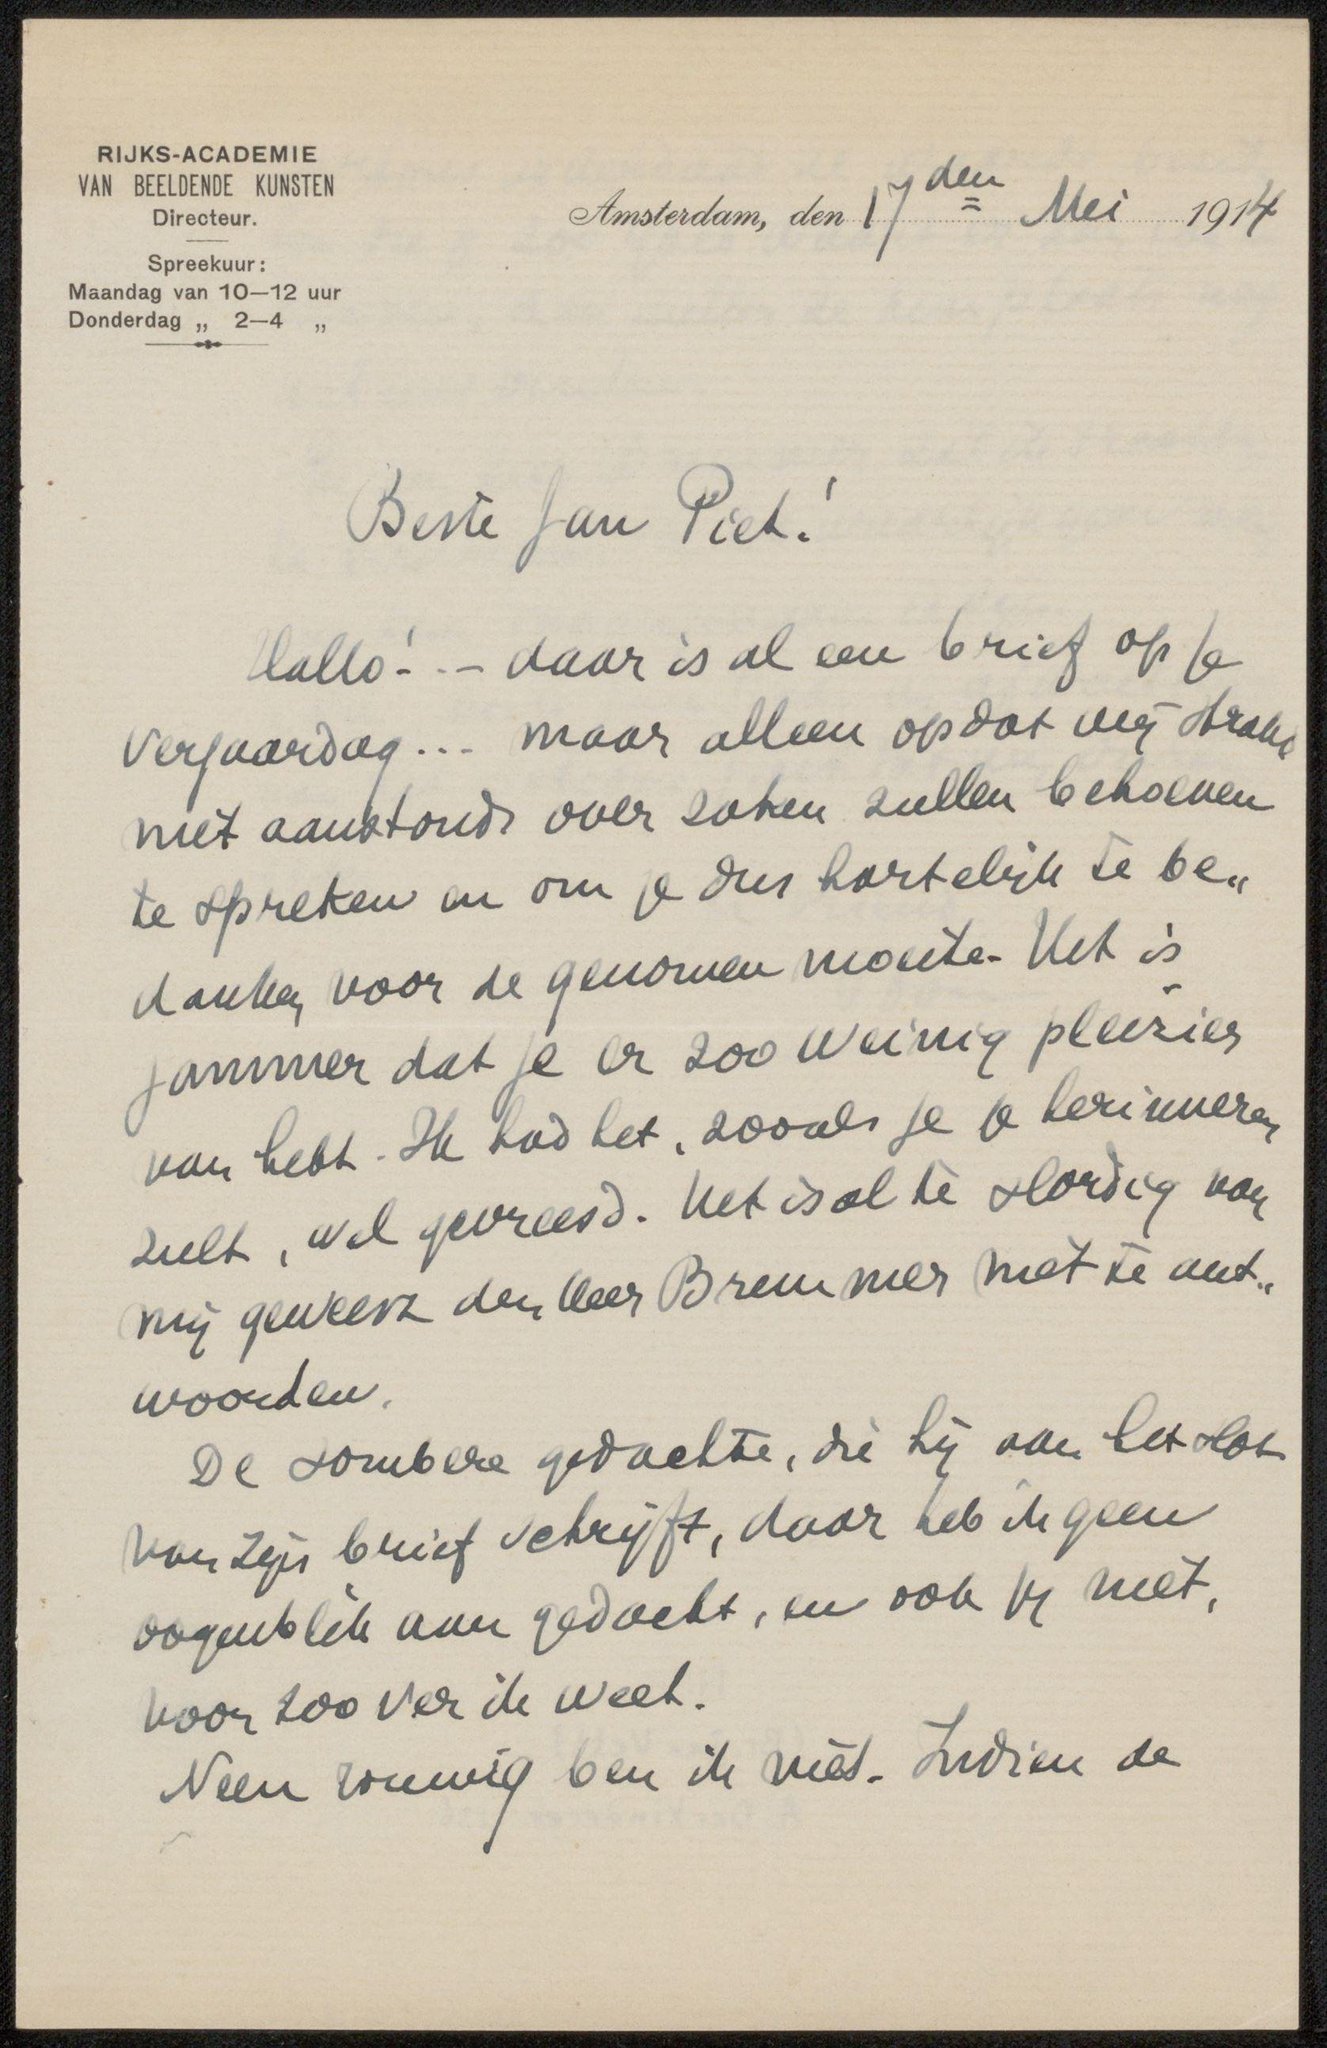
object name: letter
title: Brief aan Jan Veth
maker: antoon derkinderen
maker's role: draughtsman, painter, print maker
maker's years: 1859-1925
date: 1914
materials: ink, paper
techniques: pen, printing, writing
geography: amsterdam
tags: dordrecht, painter, print maker, draughtsman, designer, jan veth, leiden, the hague, hendricus petrus bremmer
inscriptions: collector's mark: ‘RPK’